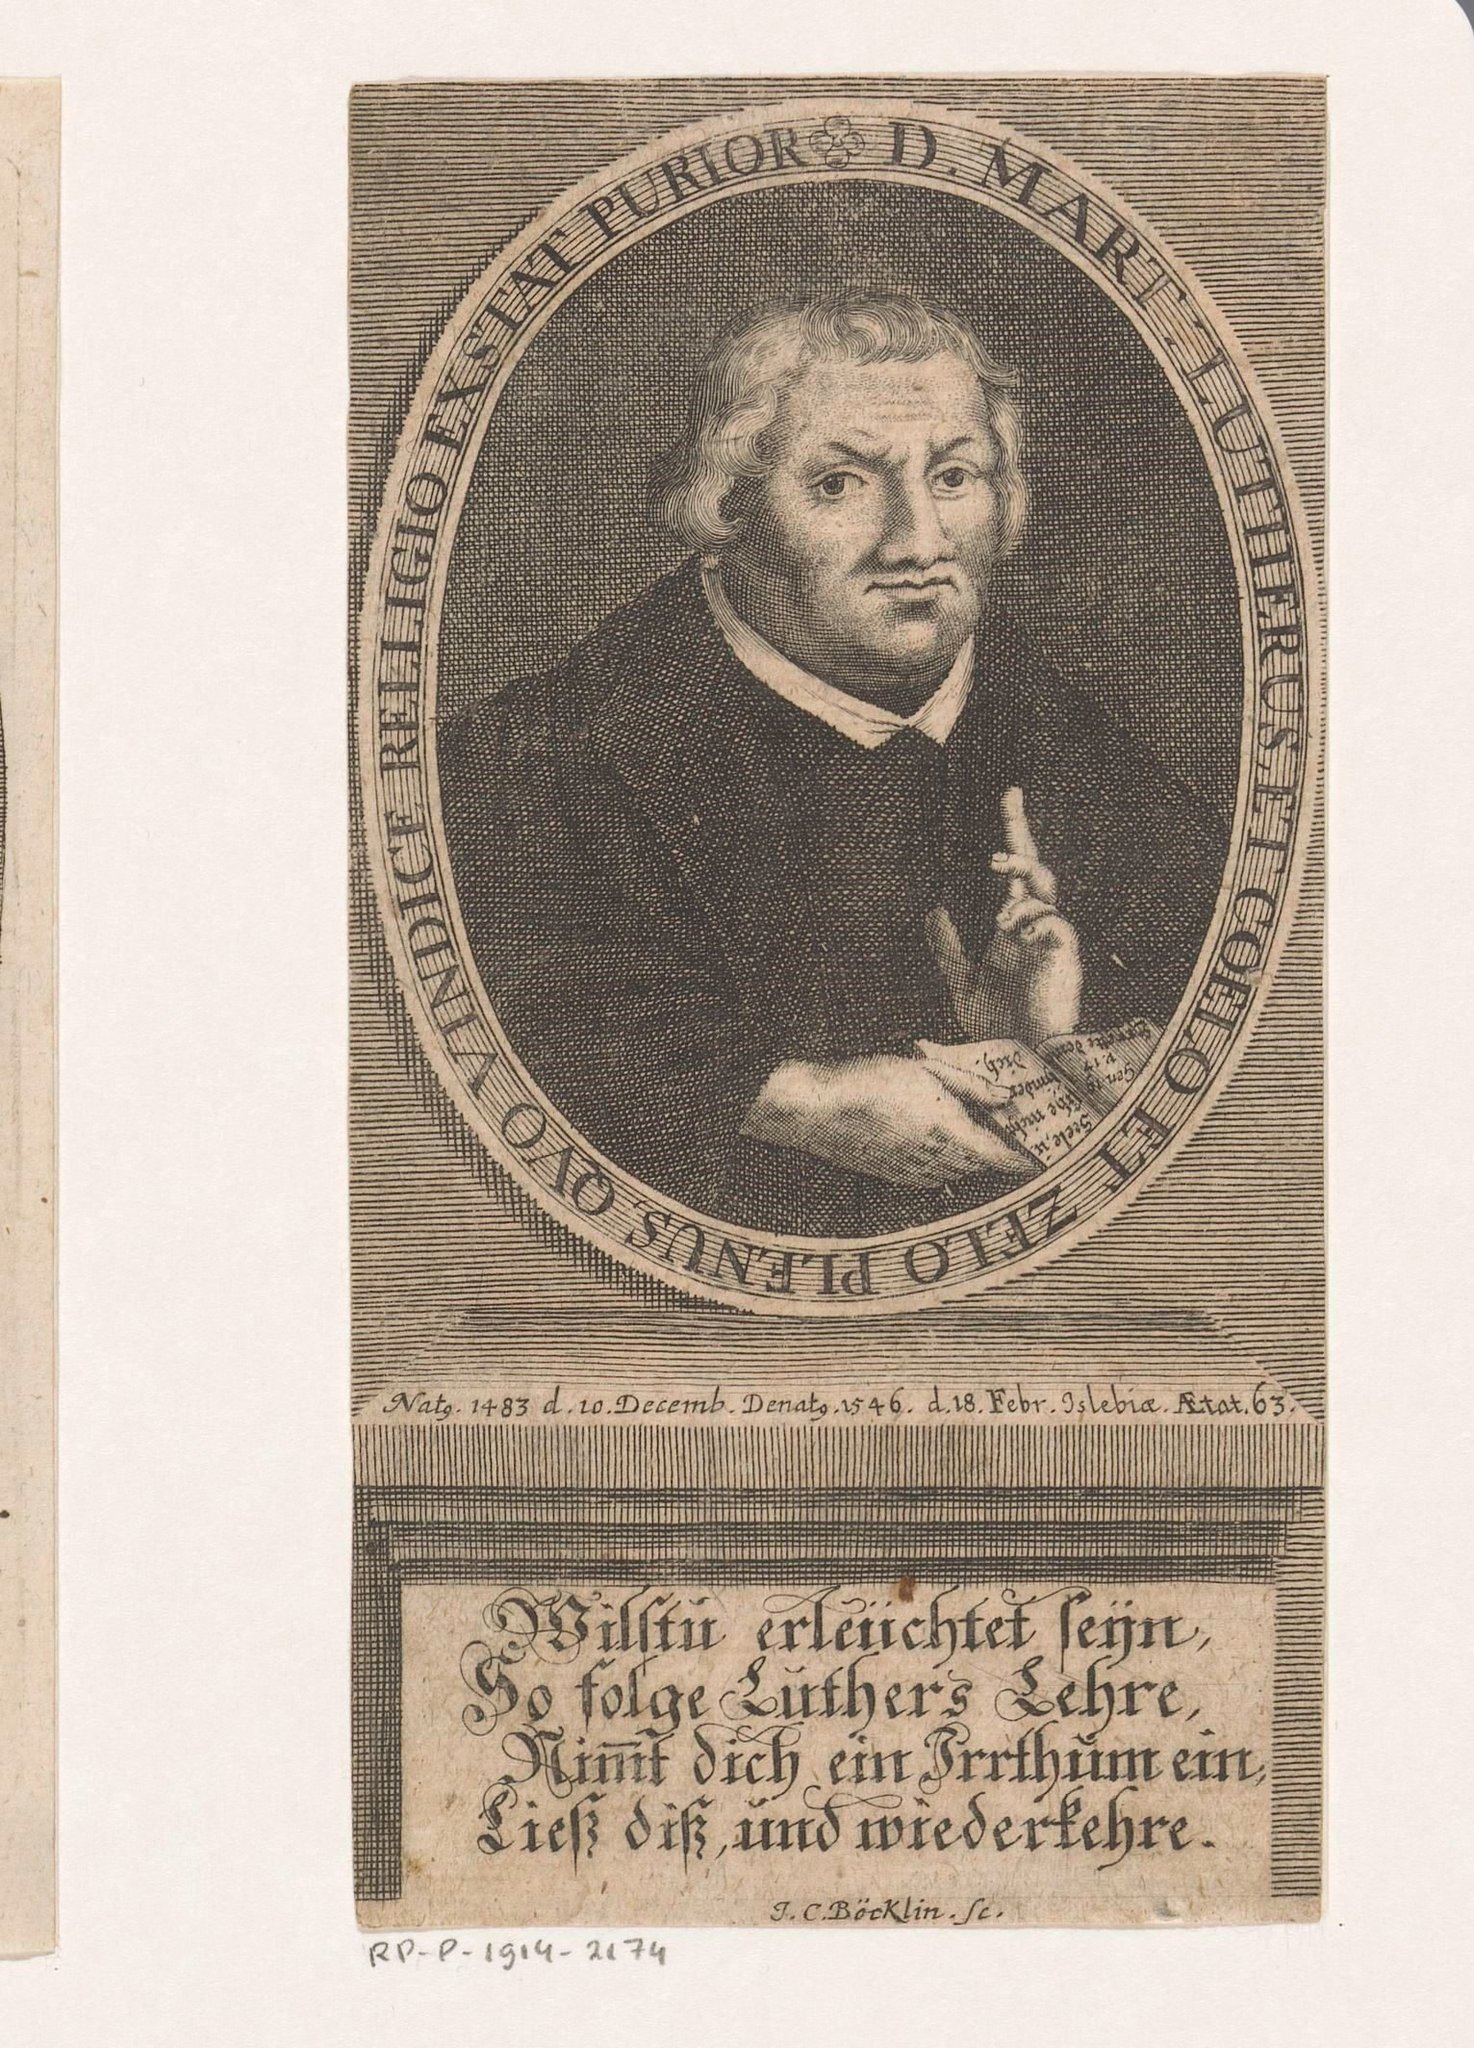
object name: print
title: Portret van Martin Luther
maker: johann christoph boecklin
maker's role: print maker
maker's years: 1657-1709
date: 1667-1709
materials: paper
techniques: engraving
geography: leipzig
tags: priest, martin luther, historical persons, book - mm - book open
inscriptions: collector's mark: Lugt 2228